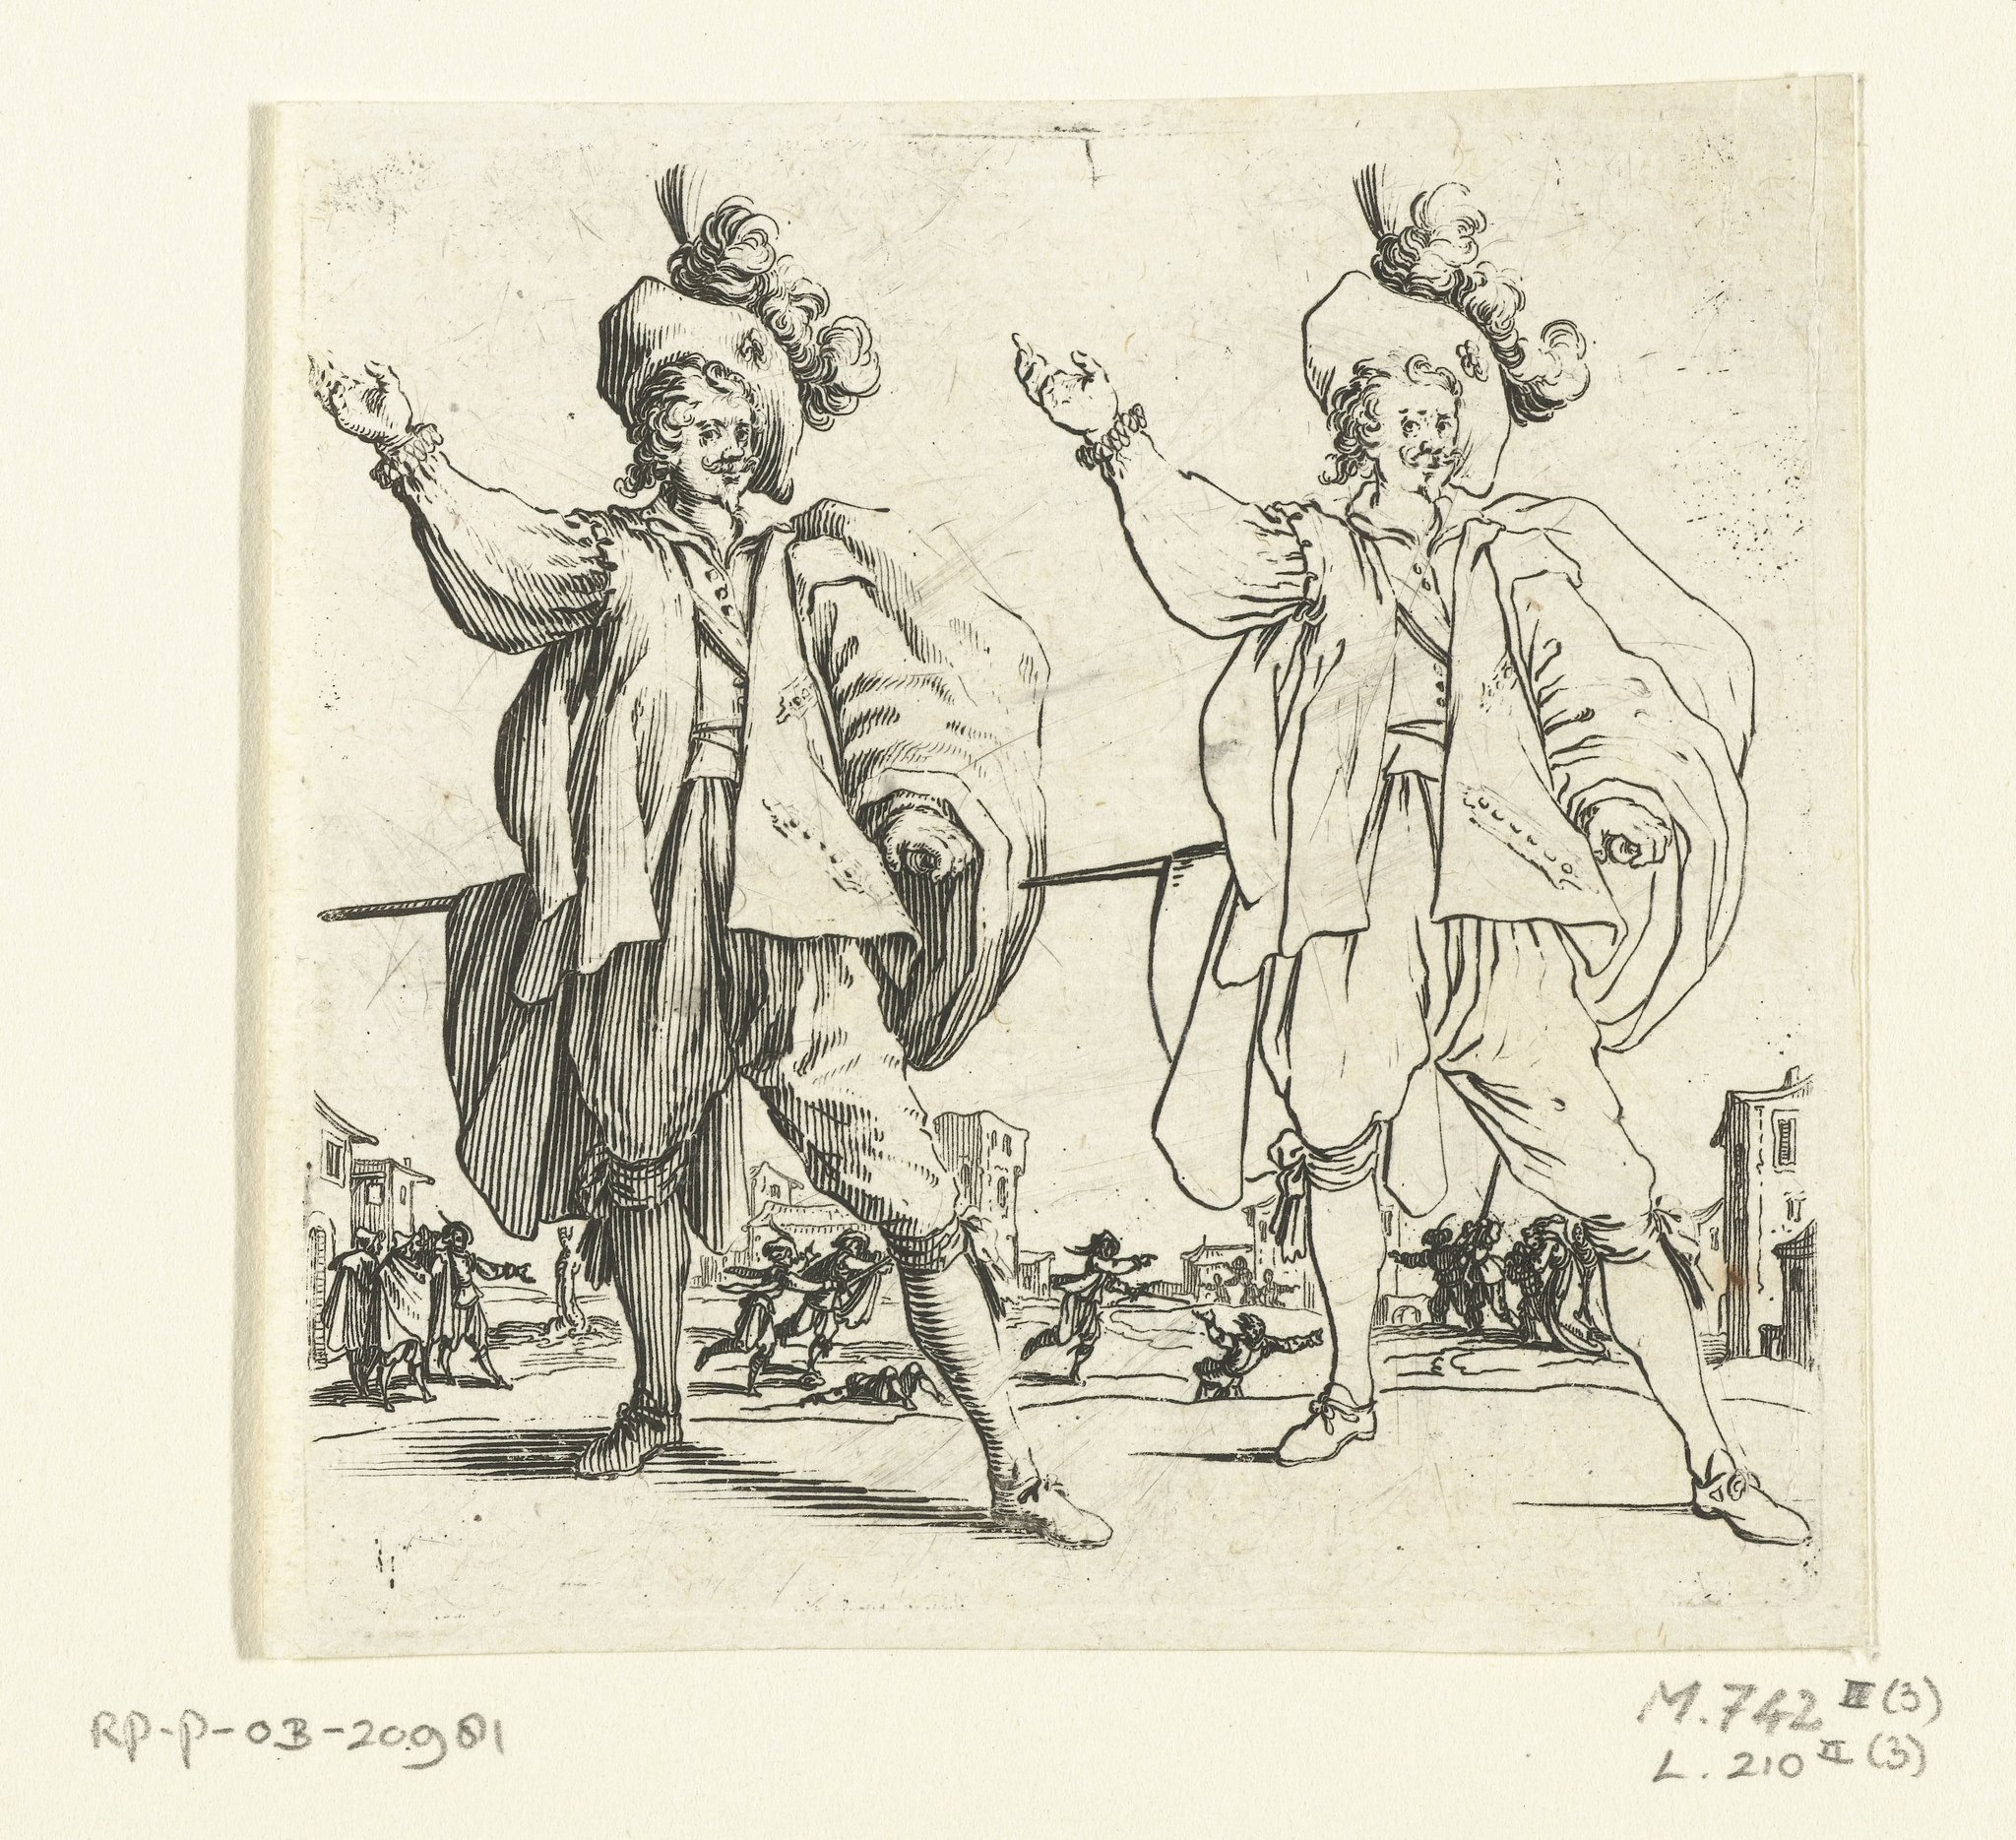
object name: print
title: Diverse figuren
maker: jacques callot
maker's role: draughtsman, print maker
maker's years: 1592-1635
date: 1621-1624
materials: paper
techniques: etching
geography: nancy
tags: coat (+ men's clothes), head-gear: hat (+ men's clothes)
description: Een soldaat met een mantel of cape over de schouder en een gepluimde hoed op het hoofd, de rechterarm opgeheven, de linkerhand op het gevest van zijn zwaard, van voren gezien, tweemaal afgebeeld: rechts als lijnfiguur, links meer uitgewerkt met schaduwpartijen. Op de achtergrond een gevecht op een dorpsplein. Deze prent is onderdeel van een serie van 16 prenten (15 volgens Lieure; 17 resp. 16 incl. titelprent) met mannen en vrouwen in diverse houdingen. Mogelijk zijn deze prenten bedoeld geweest als tekenvoorbeelden.